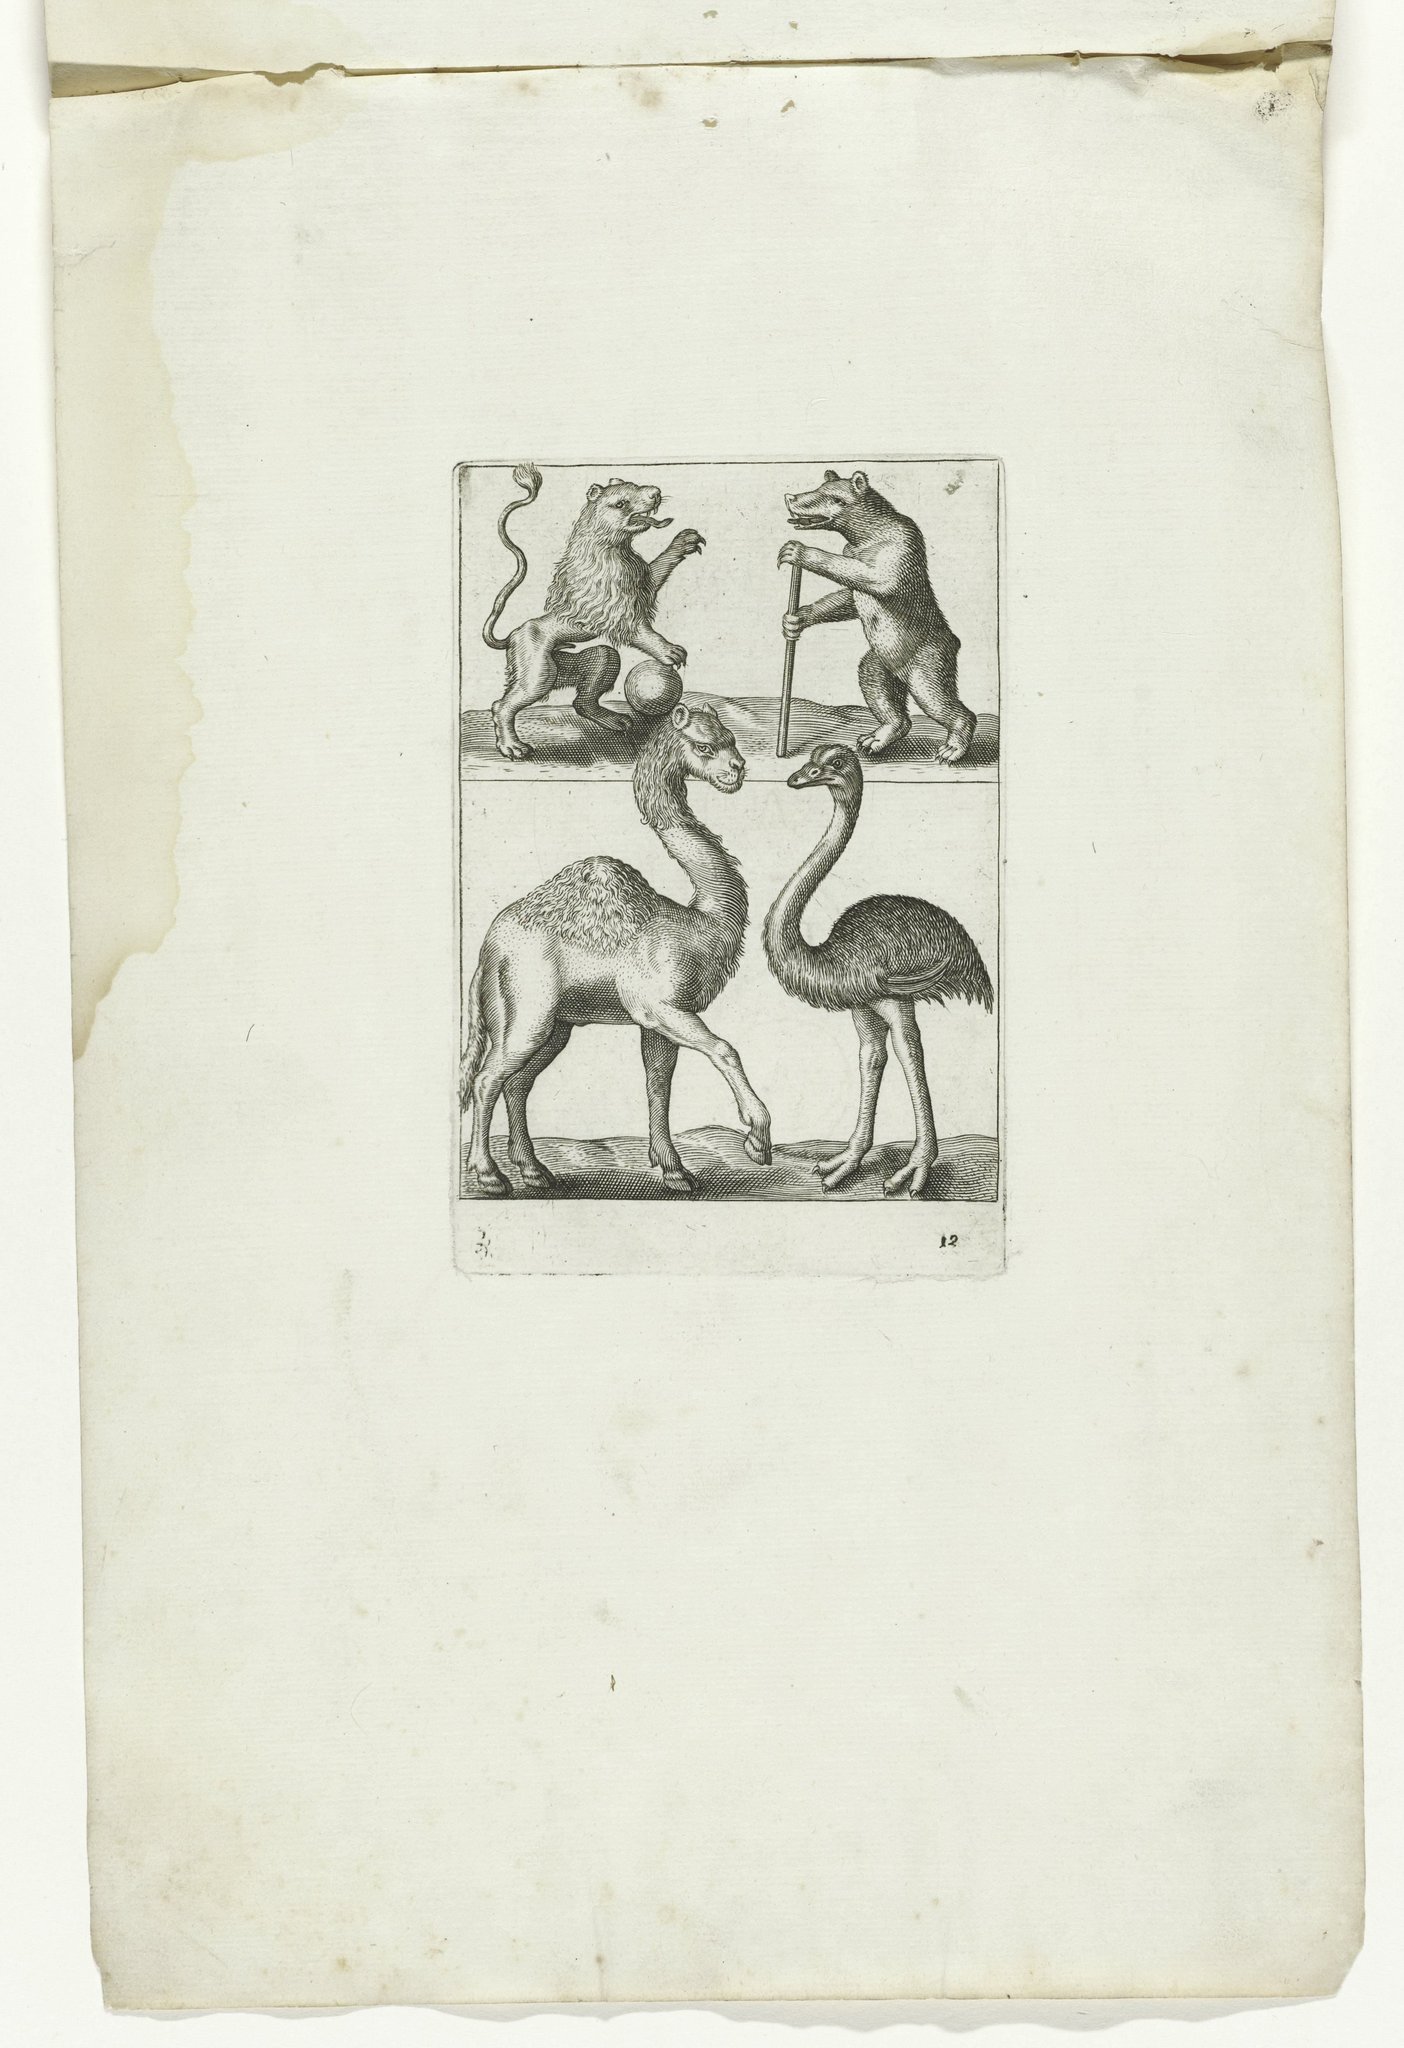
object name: print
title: Dieren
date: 1570-1668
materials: paper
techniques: engraving, etching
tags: hoofed animals: dromedary, walker and runner birds: ostrich, beasts of prey, predatory animals: bear, beasts of prey, predatory animals: lion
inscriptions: collector's mark: Lugt 2228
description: Deze serie is gekopieerd naar of het voorbeeld voor de serie Bestiarum quadrupedum Vivae Icones naar prenten van Adriaen Collaert die werd uitgegeven door Crispijn de Passe in Utrecht. Zie New Hollstein Dutch, The Collaert Dynasty, dl. VI, p. 168, cat.nrs. 1462-1481 copy b.